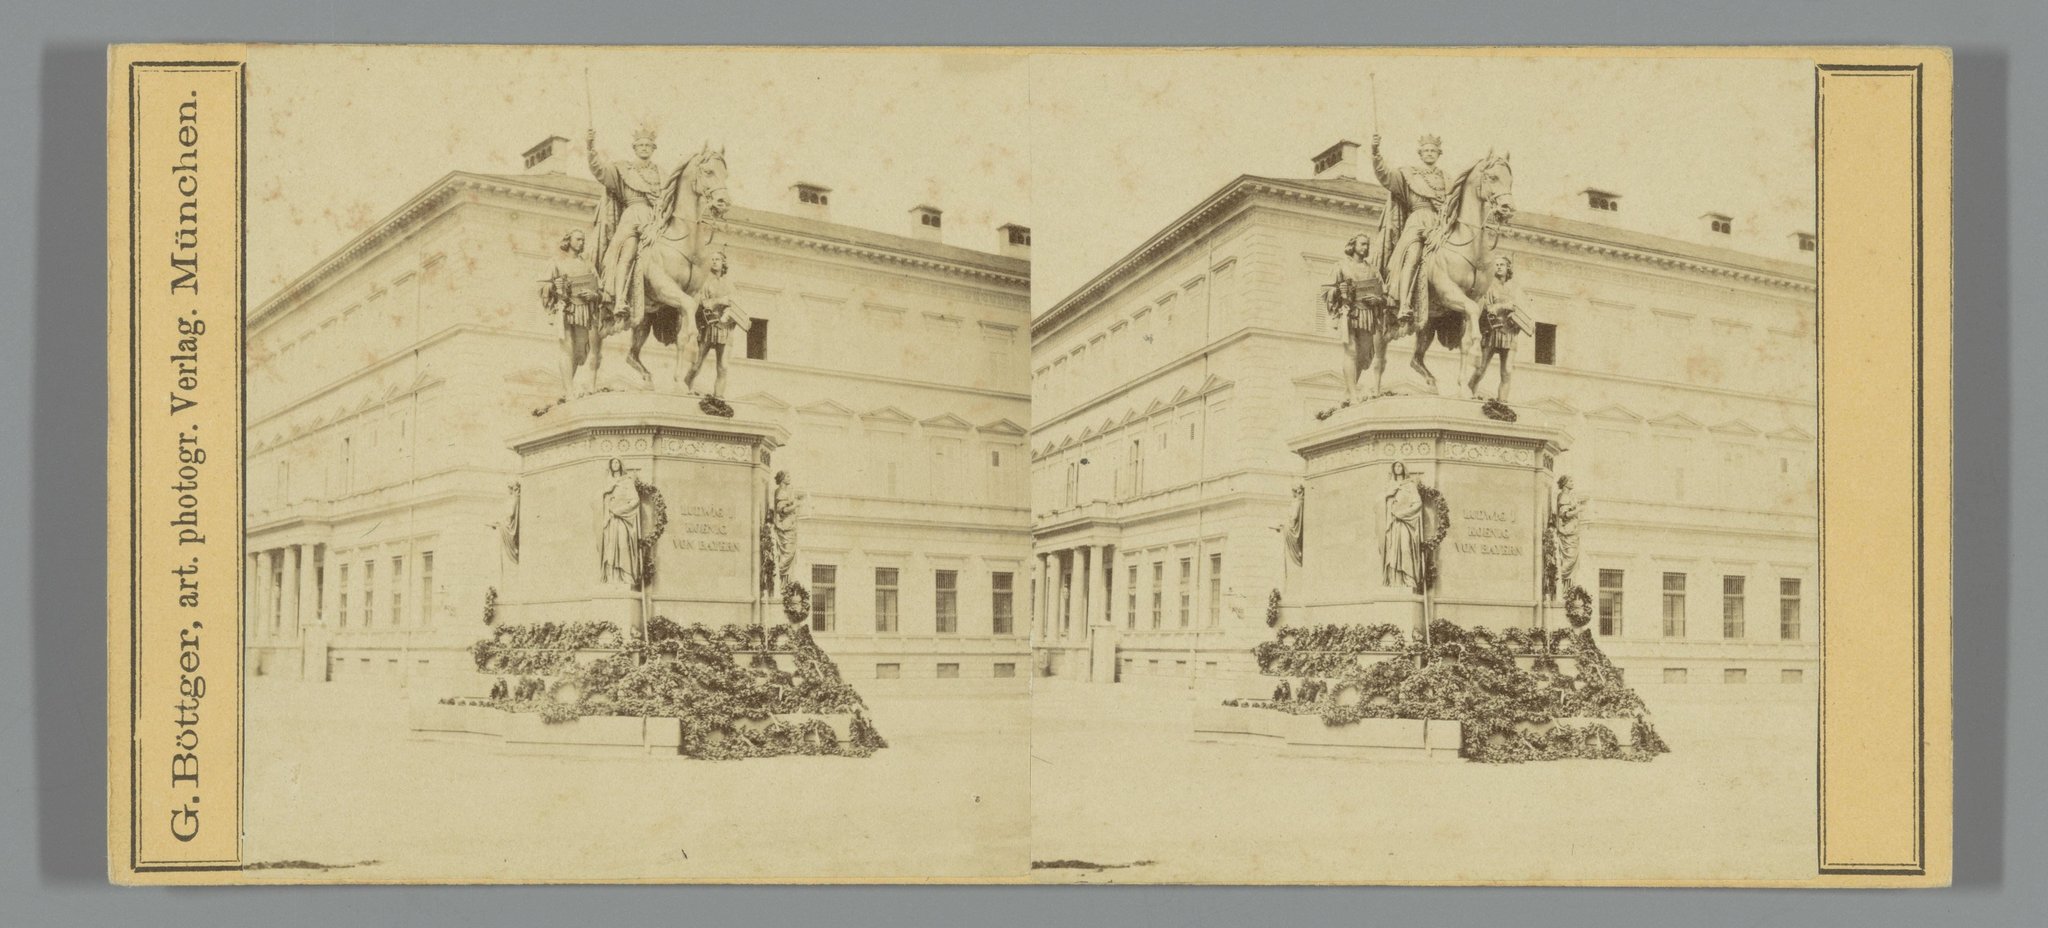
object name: stereograph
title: Ruiterstandbeeld van koning Lodewijk I van Beieren te München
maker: georg böttger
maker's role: fotograaf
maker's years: 1821-1902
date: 1860-1885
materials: cardboard, photographic support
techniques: albumen print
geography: munich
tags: equestrian statue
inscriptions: number: ‘G. 5.’